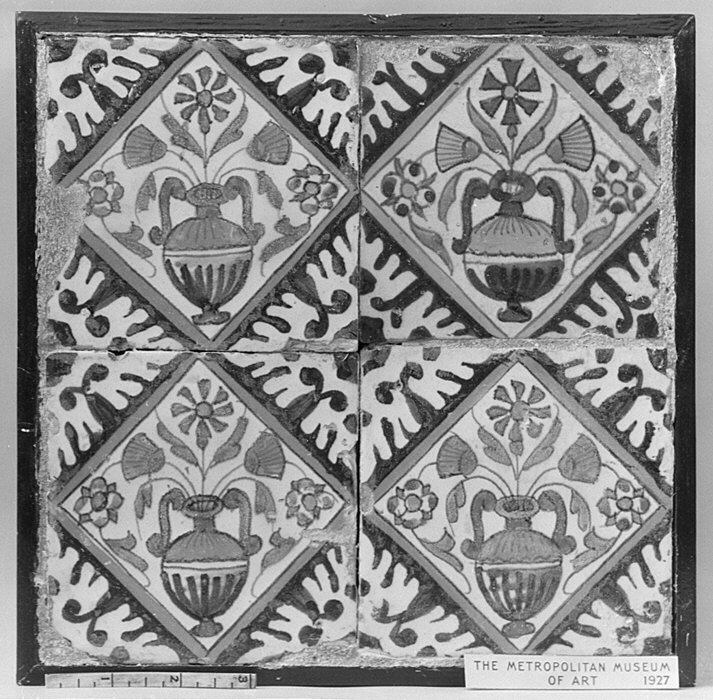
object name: tile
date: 1580-1620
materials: earthenware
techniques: glazing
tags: flowers